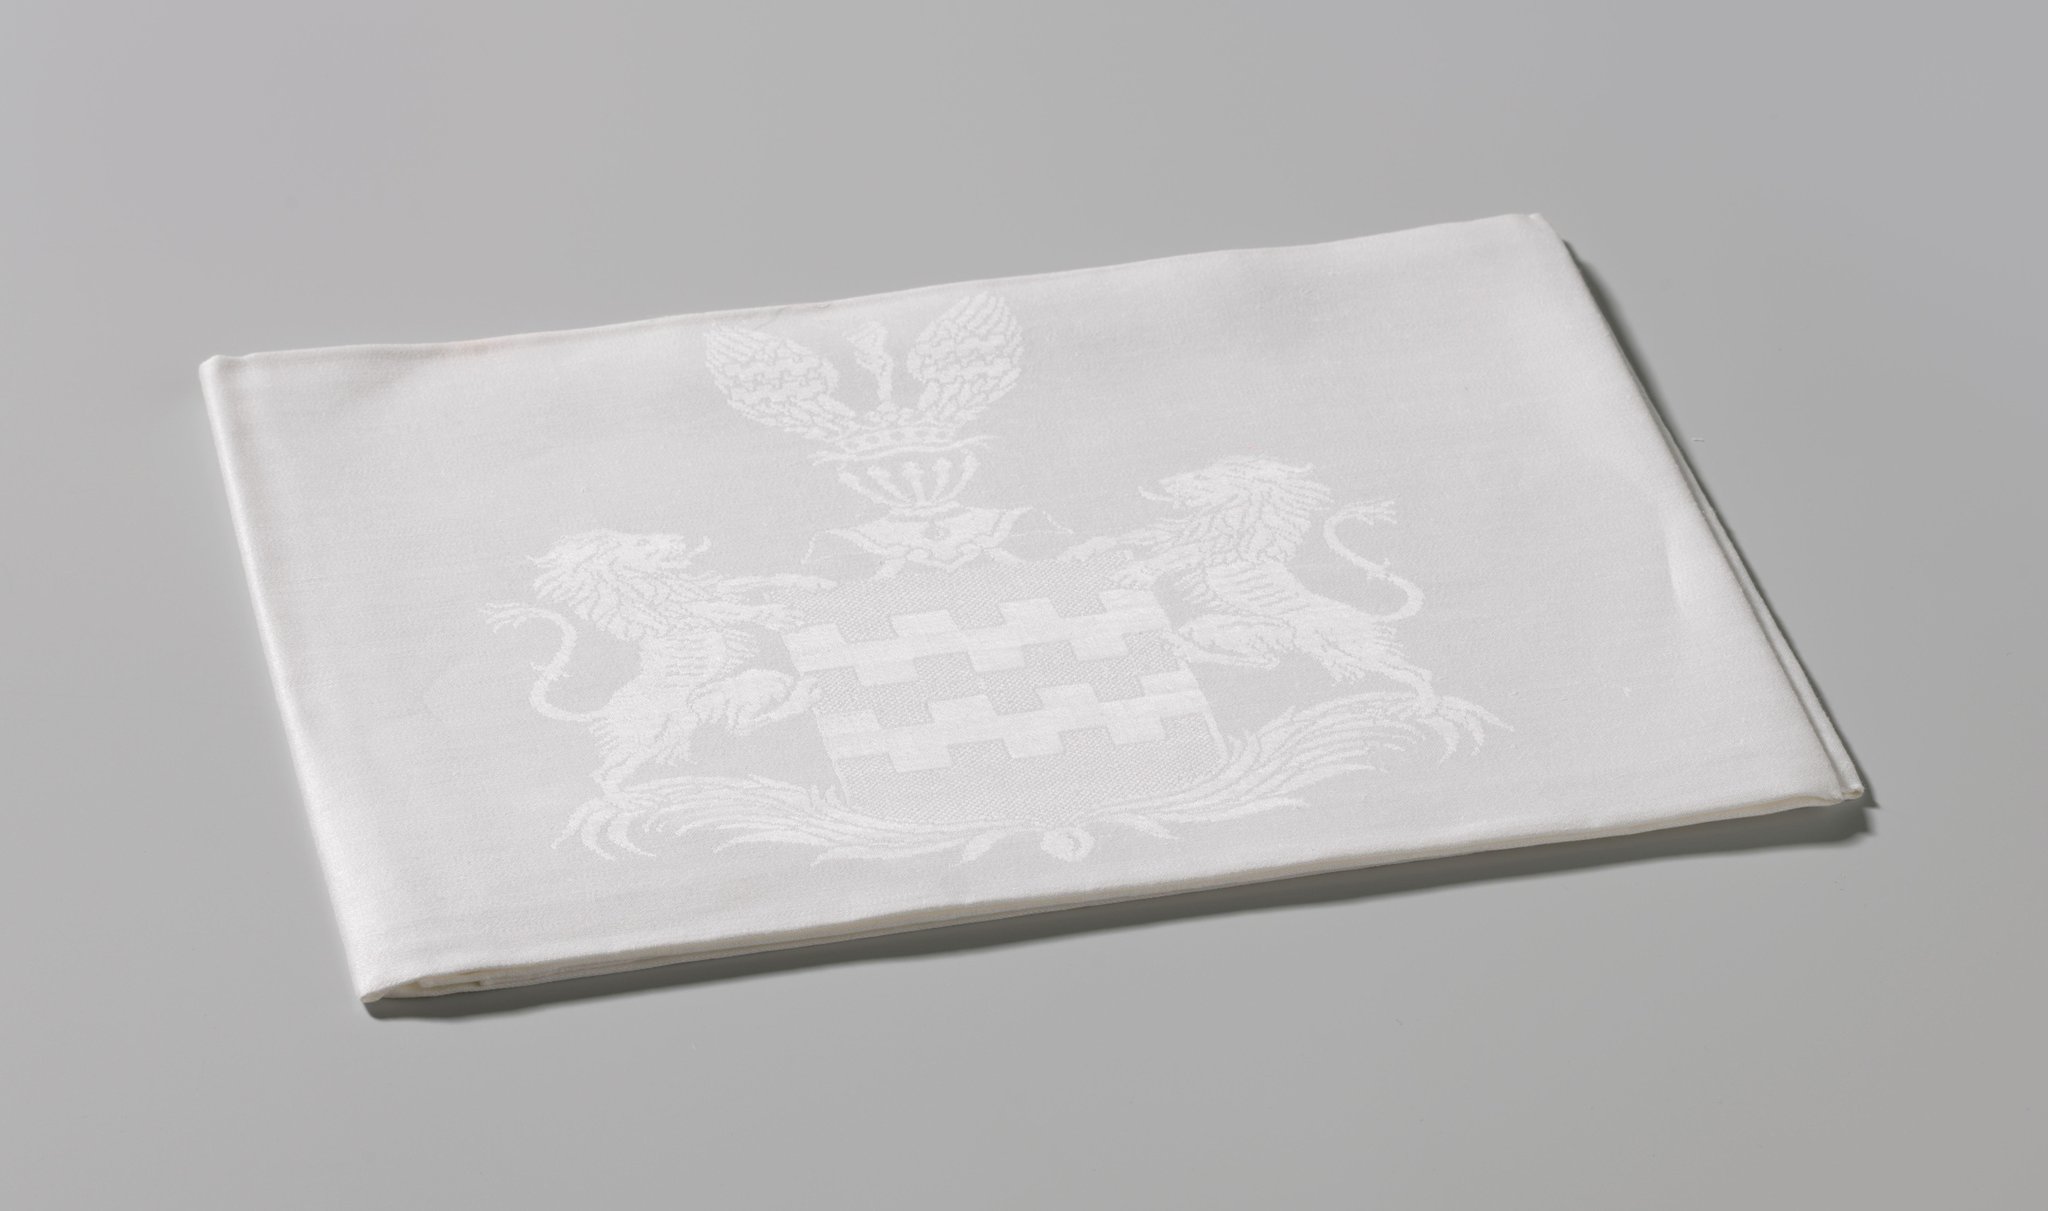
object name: napkin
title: Servet van wit linnendamast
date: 1874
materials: linen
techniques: damask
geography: north brabant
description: Wit linnen damasten servet met voluten en het wapen Van Boelens van der Haer.